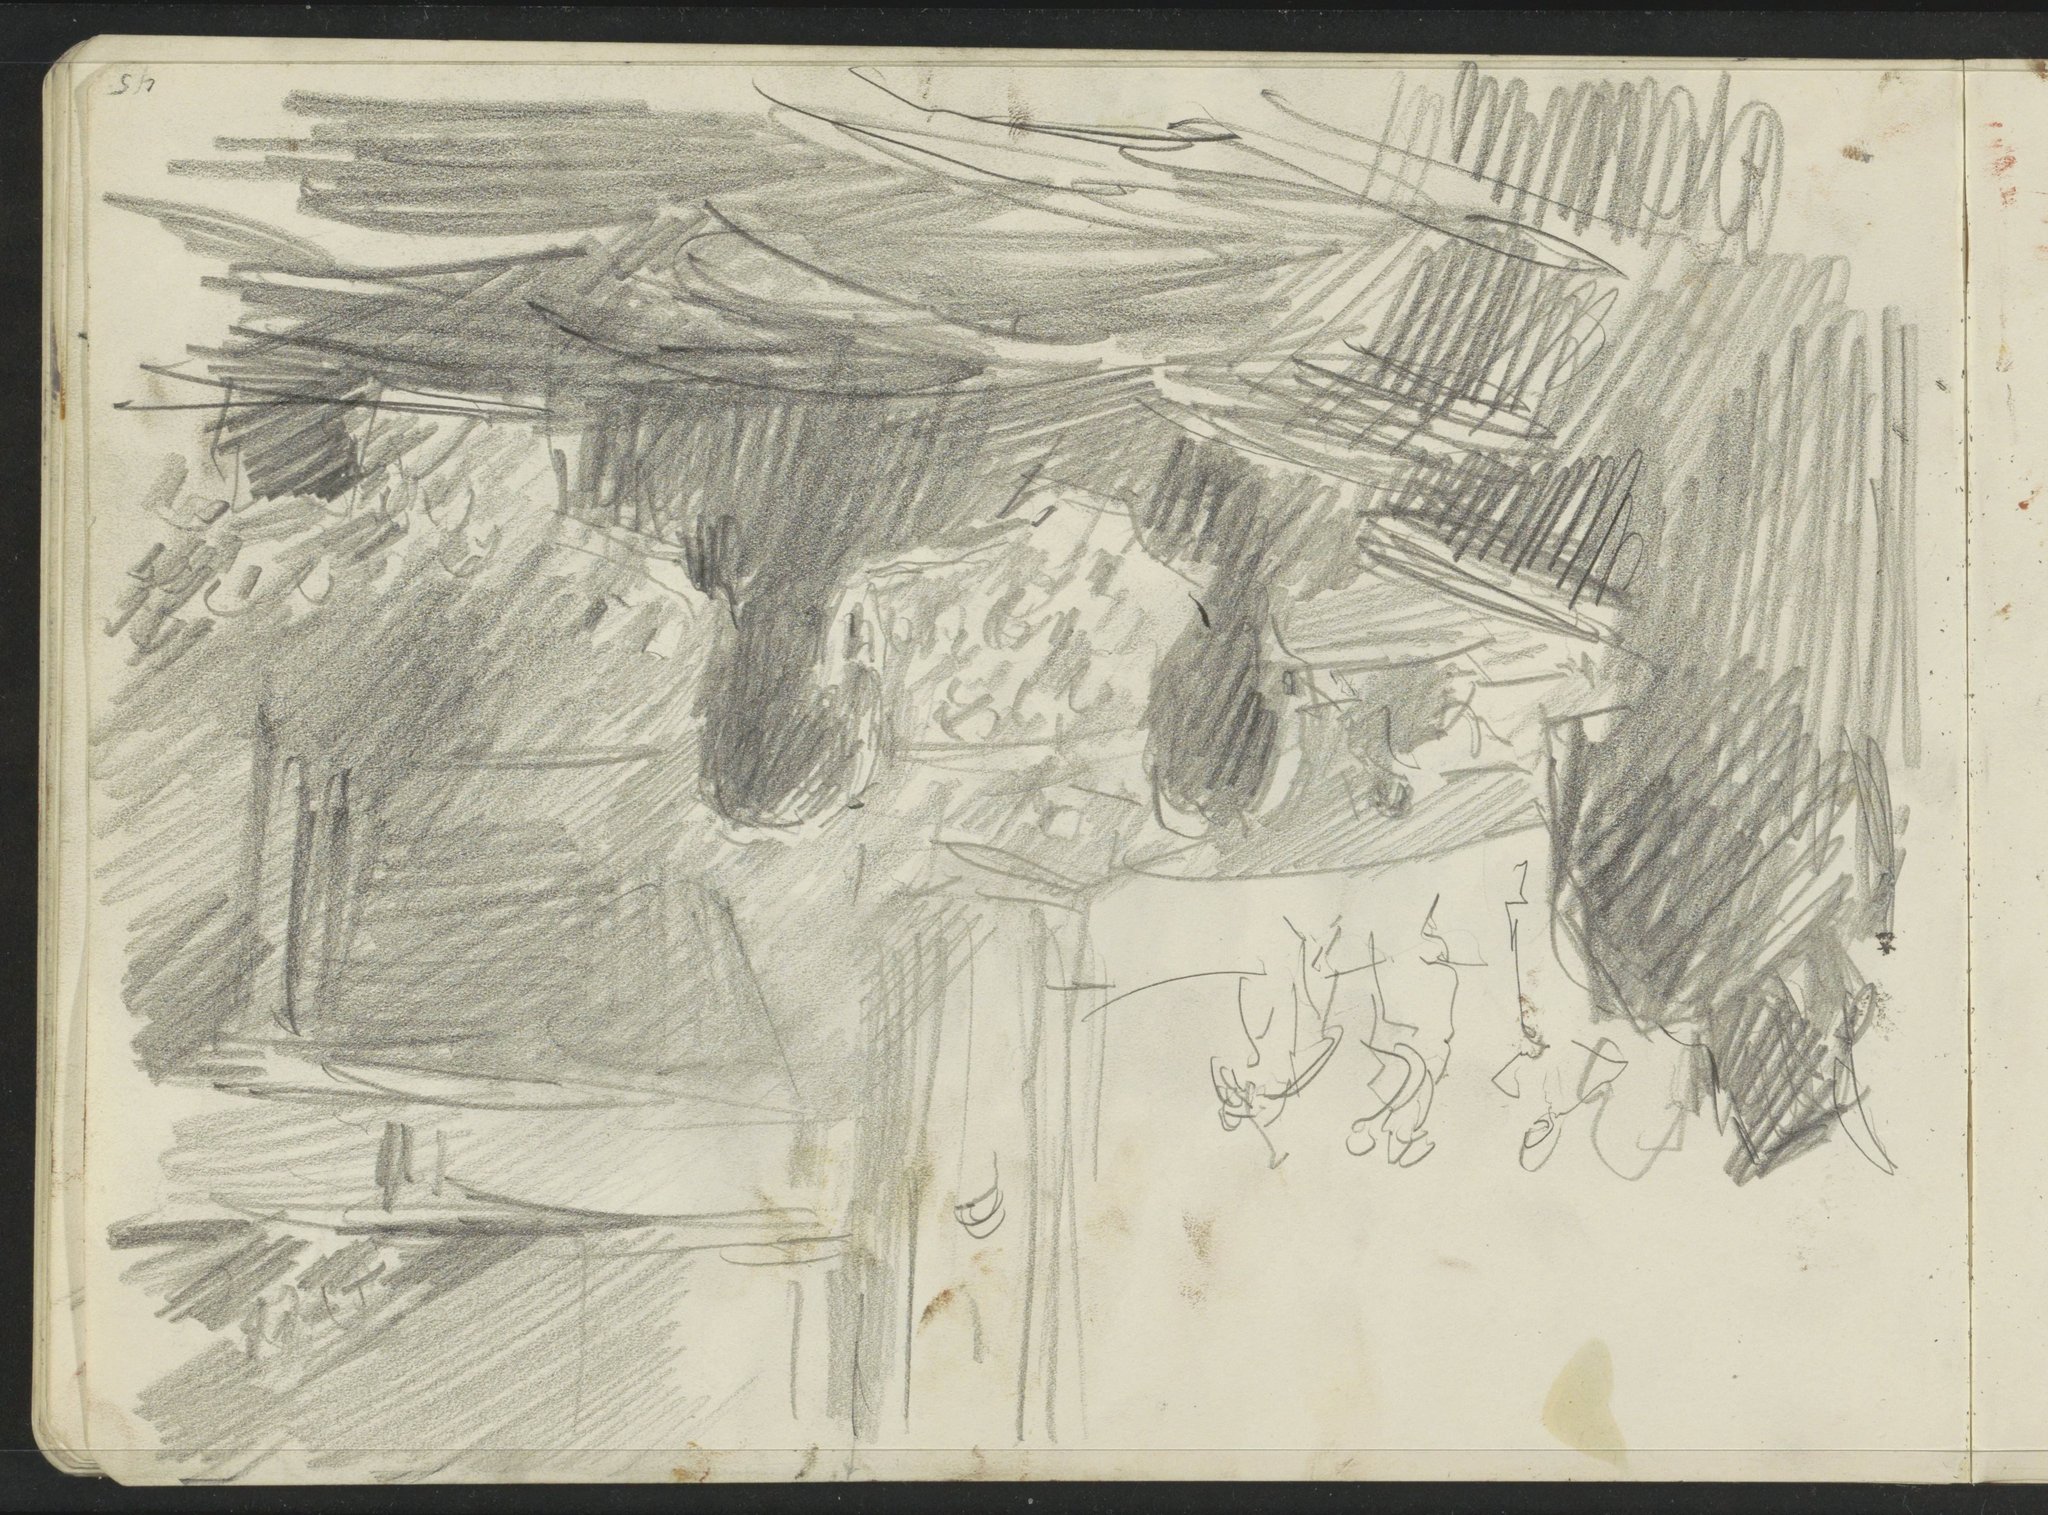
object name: sketchbook leaf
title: Theatervoorstelling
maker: isaac israels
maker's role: draughtsman, painter, print maker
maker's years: 1865-1934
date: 1915-1934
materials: paper, pencil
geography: the hague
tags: boxes, loges ~ theatre, etc., the audience ~ art performance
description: Vooraan toeschouwers op een balkon, op de rug gezien. Blad 26 verso uit schetsboek XVIII met 35 bladen.